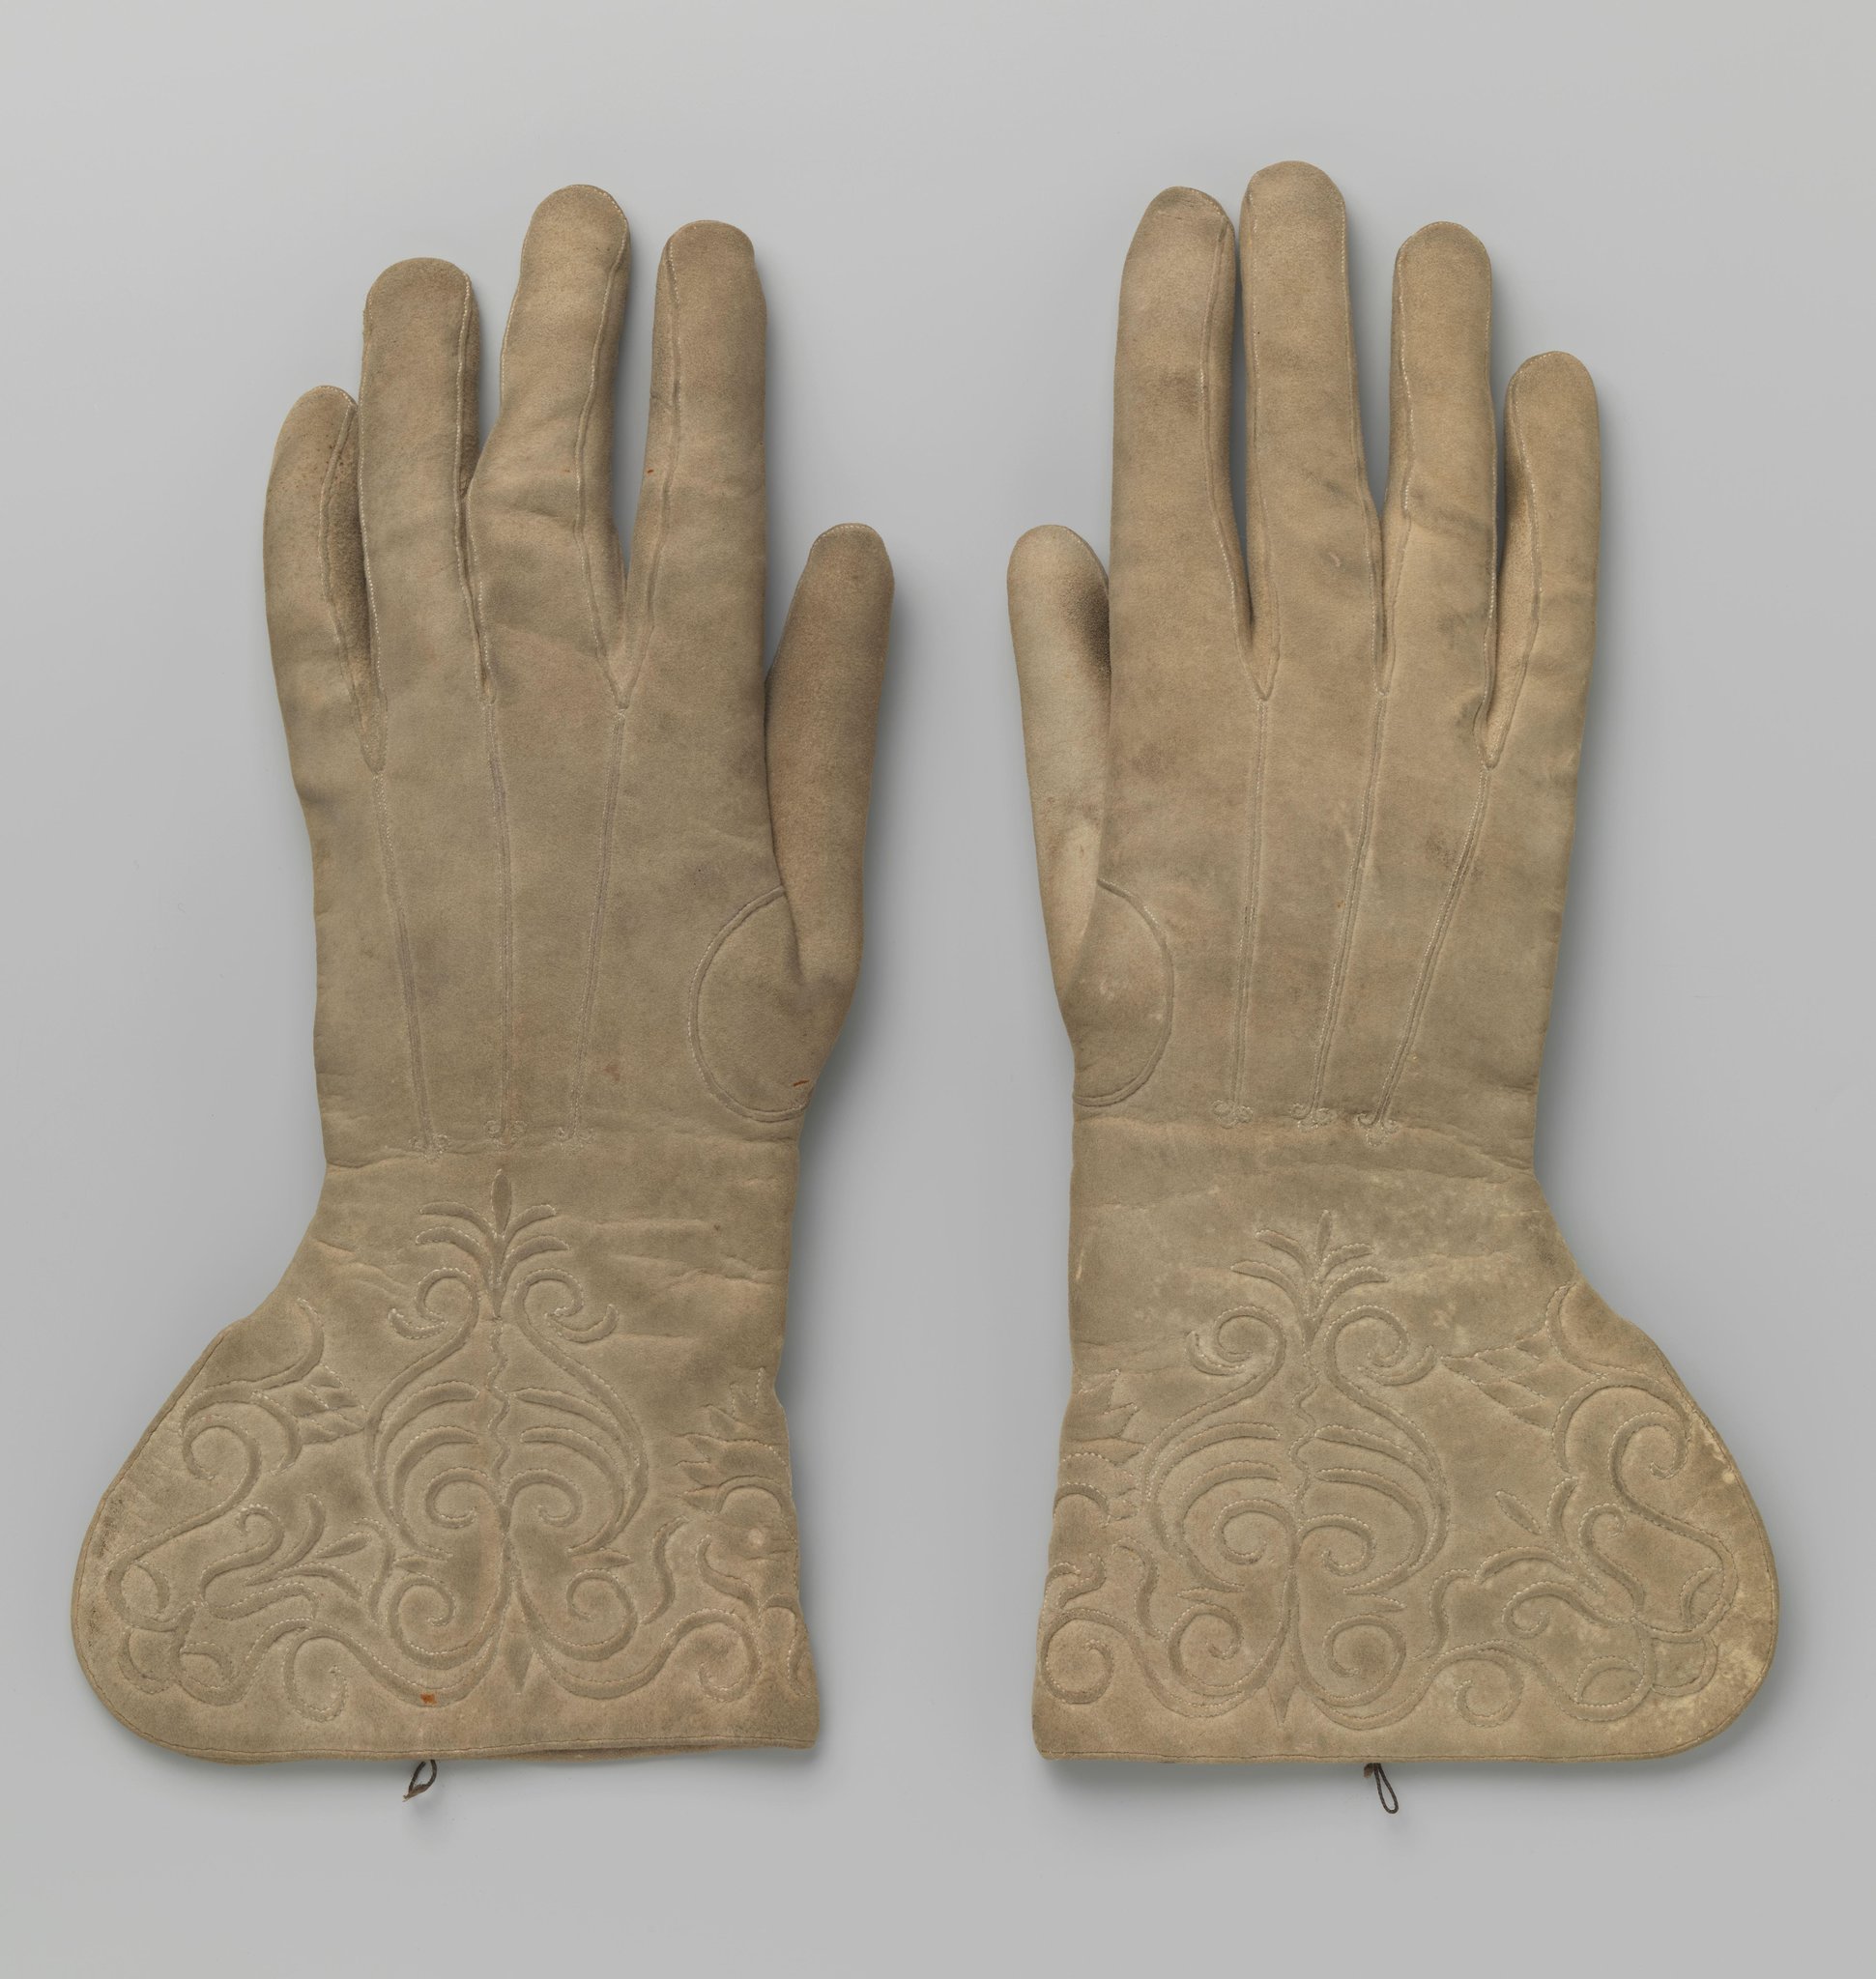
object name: glove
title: Handschoenen van beige vilt. Versierd met bloemenpatroon op de kap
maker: Anonymous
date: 1723-1749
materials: wool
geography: western europe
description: Linker handschoen van beige vilt. Versierd met bloemenpatroon op de kap aan binnen en buitenzijde. Op de rug drie uitstralende koorden. Geheel gevoerd met vilt. Handschoen van de Haarlemse reus D. Cajanus.